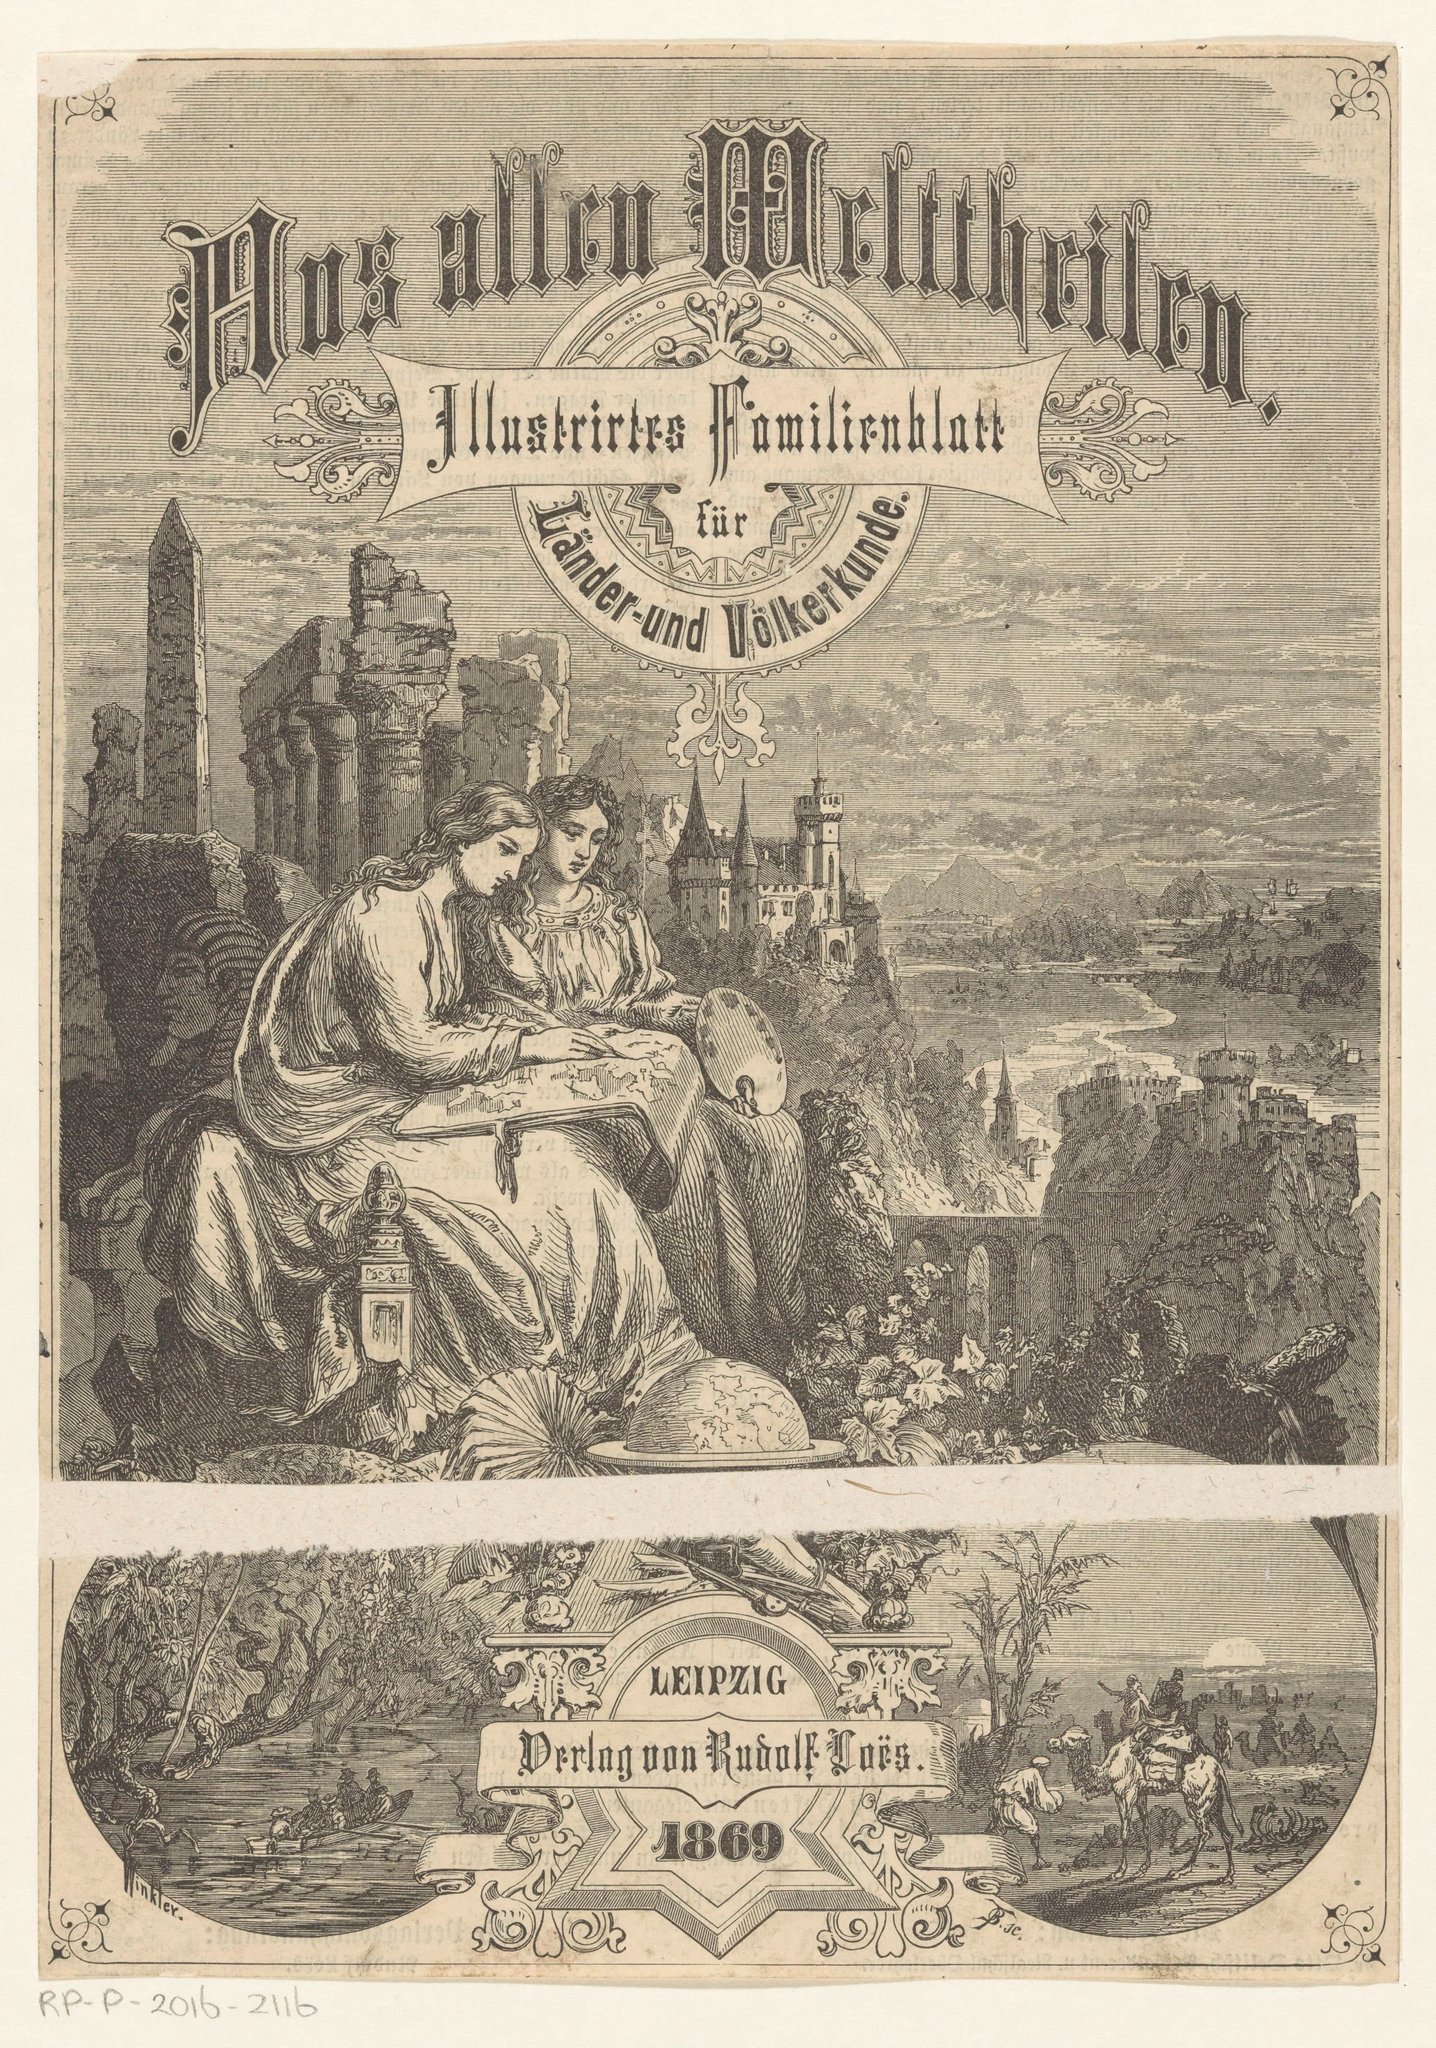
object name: titelblad, titelpagina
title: Twee vrouwen in een landschap met ruïnes en kastelen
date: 1869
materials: paper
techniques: etching, letterpress printing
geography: leipzig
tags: drawing, castle, landscape with ruins, riding on animal other than horse, ass, or mule, boat propelled by man or animal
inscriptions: collector's mark: Lugt 2228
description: Een tekenende vrouw en een vrouw met schilderspalet zitten naast elkaar voor ruïnes. In de achtergrond een landschap met twee kastelen. Aan de onderzijde twee ronde medaillons met figuren varend in een boot en figuren rijdend op kamelen.